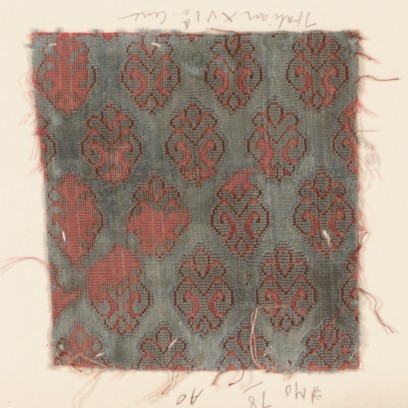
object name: fragment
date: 1501-1600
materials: silk